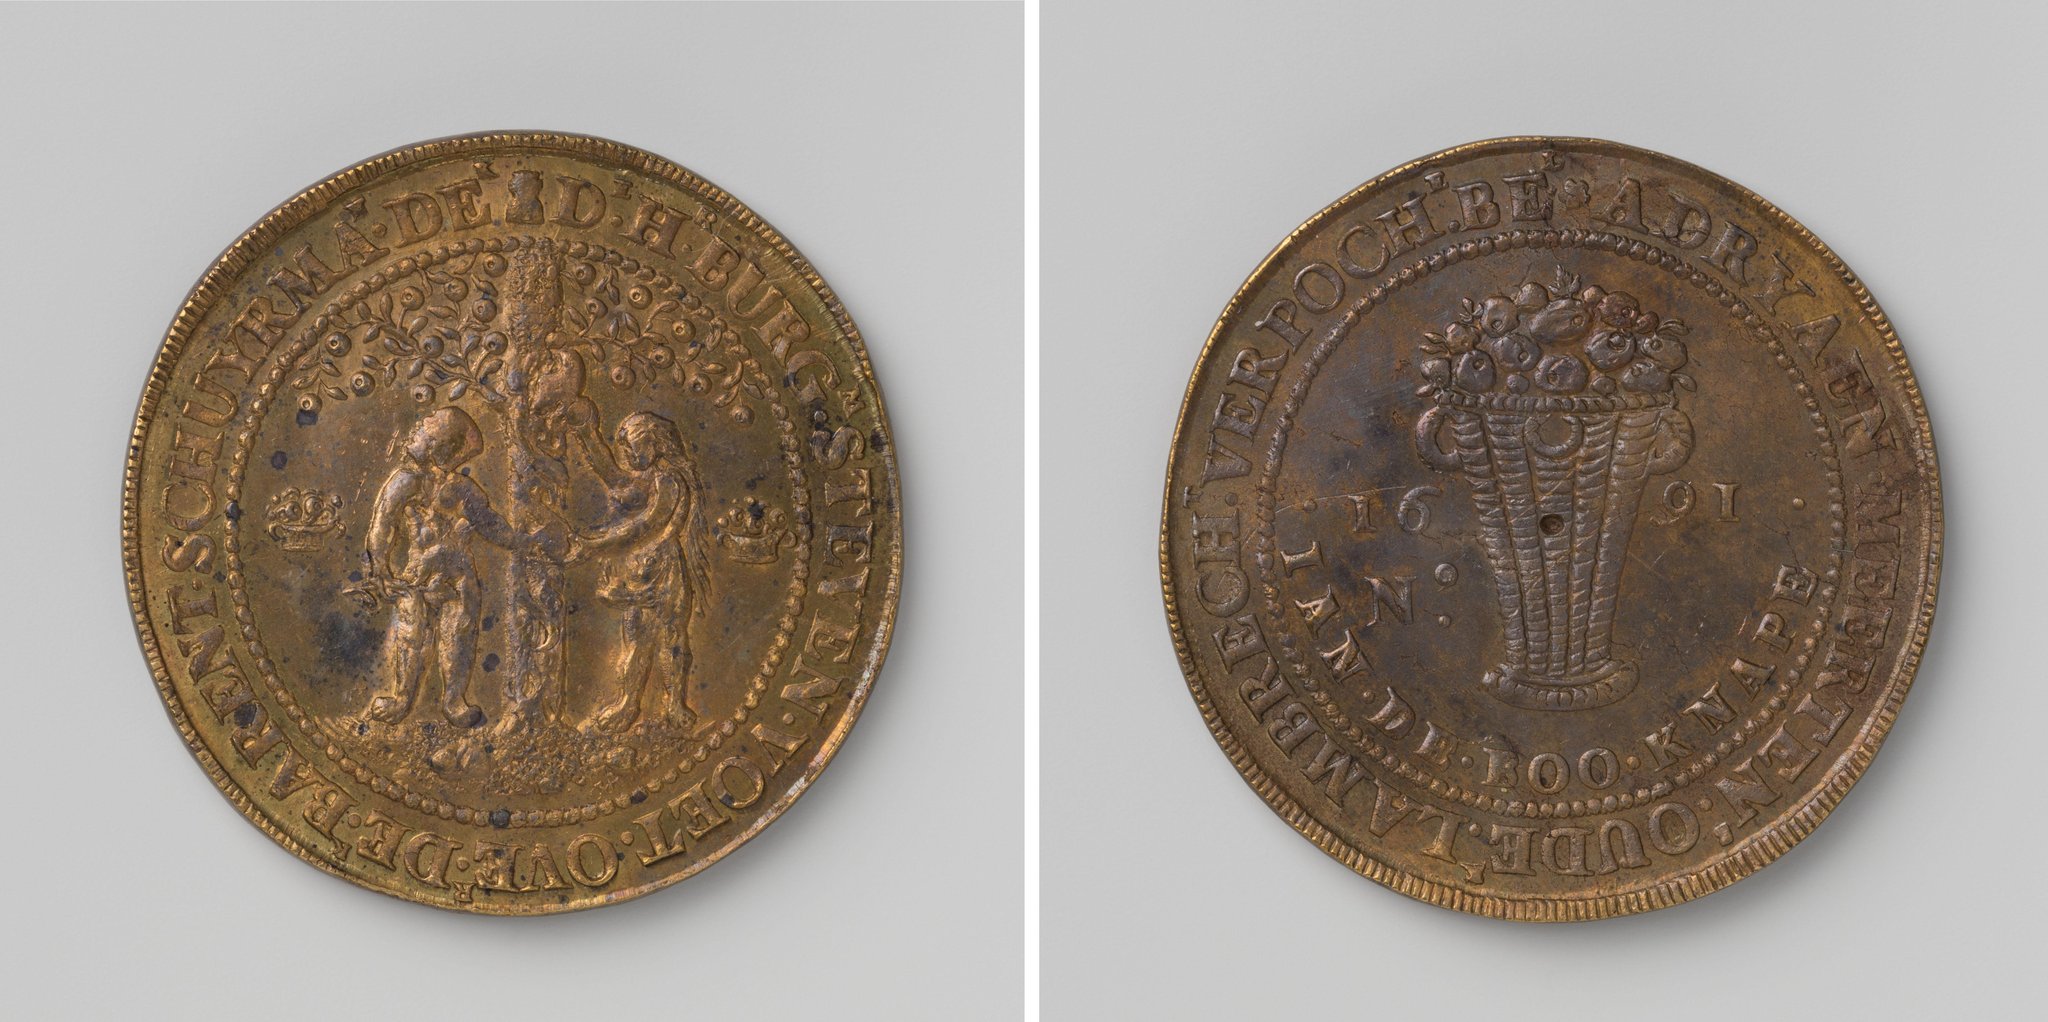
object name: medal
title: Fruiteniersgilde van Middelburg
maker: Anonymous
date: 1691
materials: brass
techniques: casting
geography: middelburg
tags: middelburg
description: Guilds were urban organisations of people in specific occupations. The guild represented the interests of the profession. Each member had a token as proof of membership. The person’s name was engraved on one side of the token, often together with the arms of the guild or of the city in which it was based. The other side carried a motif signifying the occupation represented by the guild.